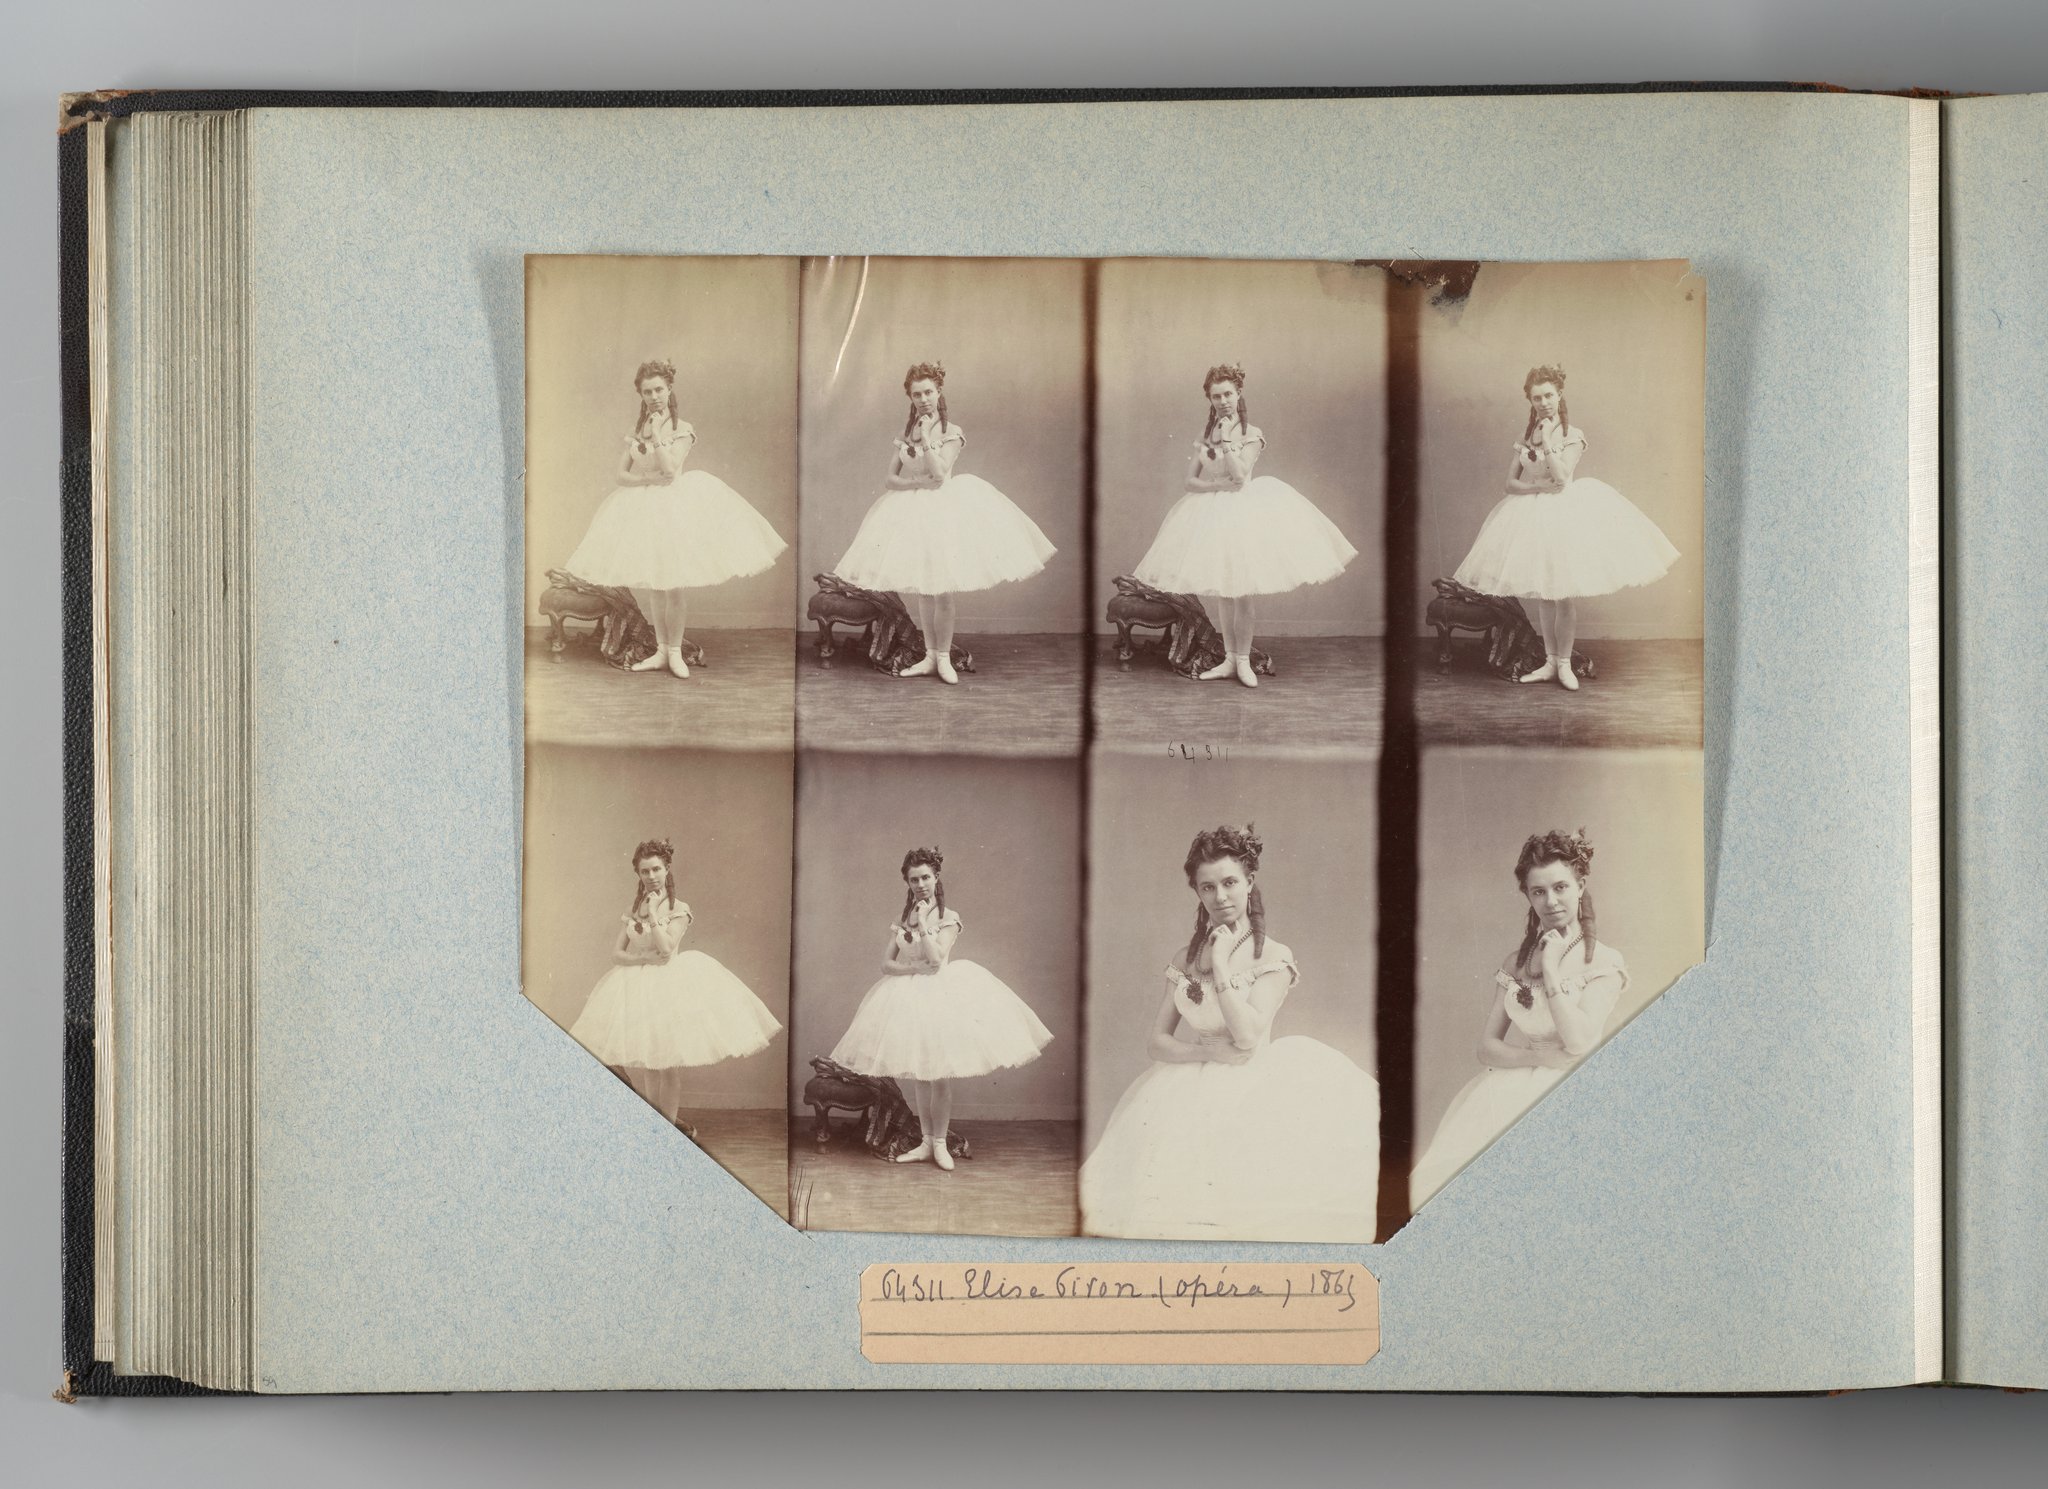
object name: photograph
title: Elise Piron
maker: andré-adolphe-eugène disdéri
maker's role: artist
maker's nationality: french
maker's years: 1819-1889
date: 1865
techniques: albumen silver print, glass negative